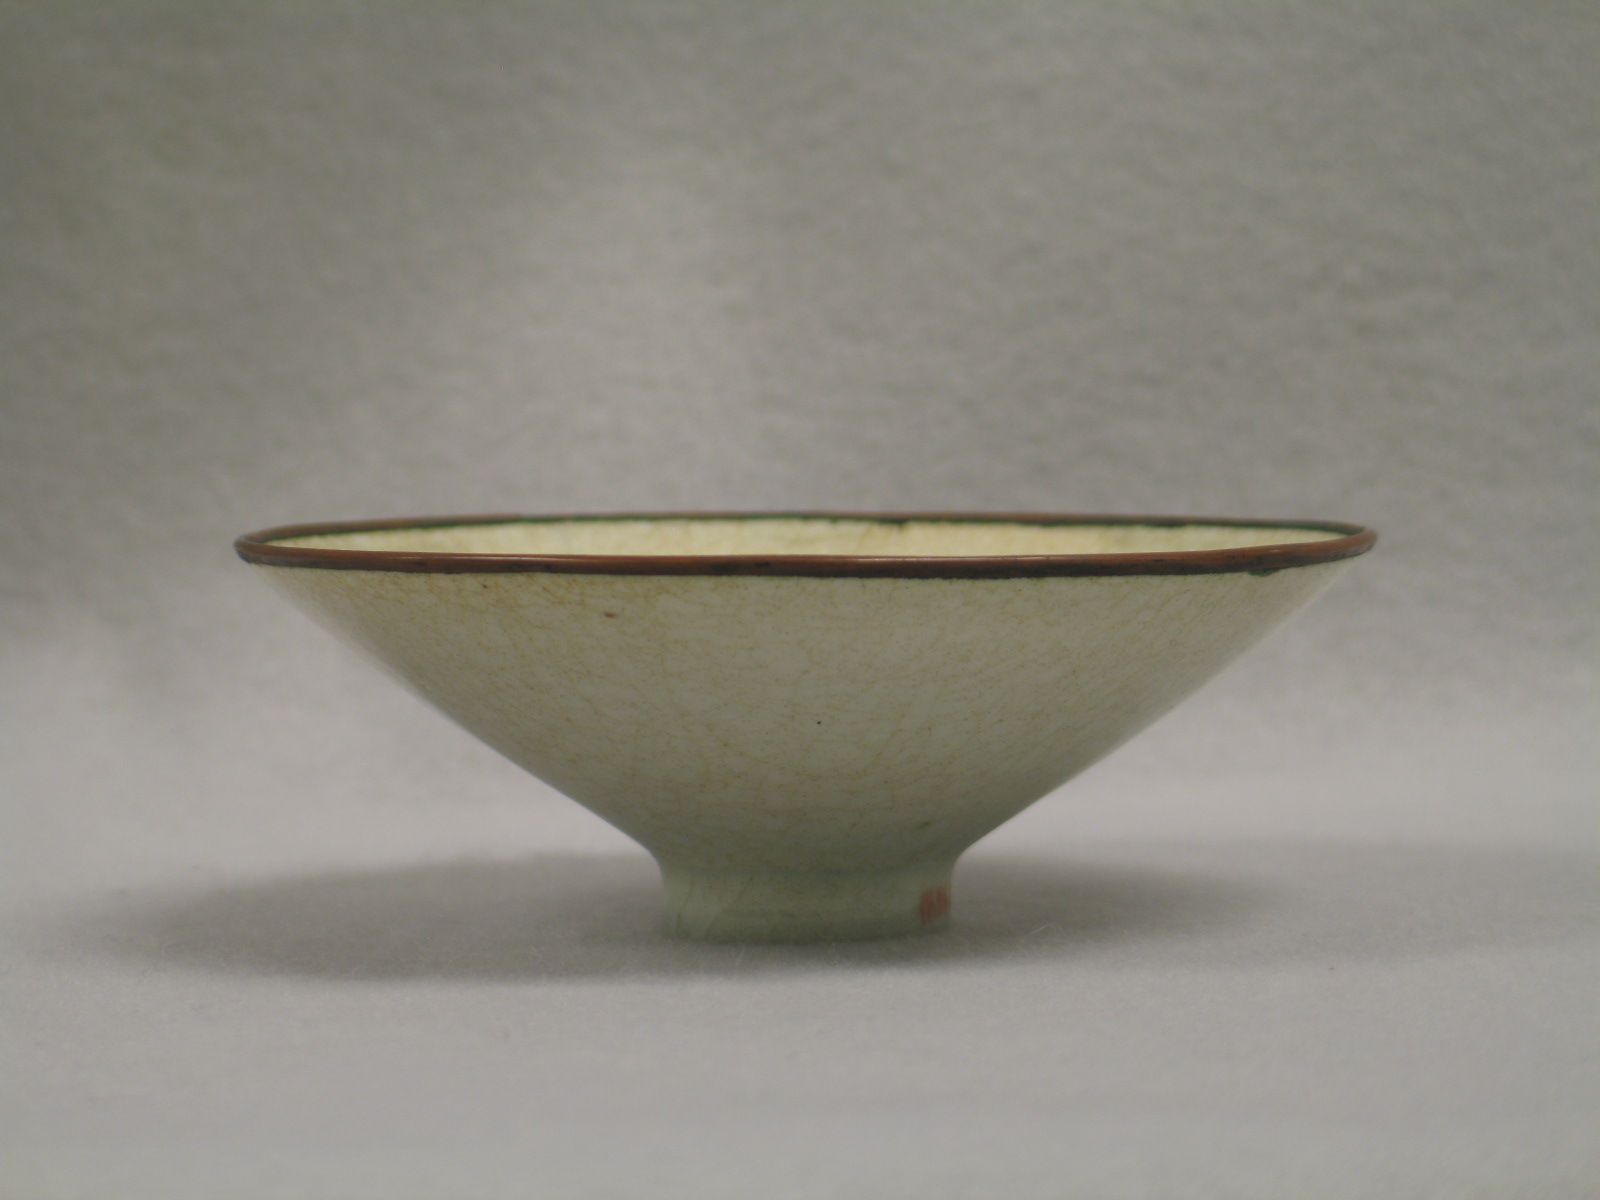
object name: bowl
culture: chinese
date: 1101-1300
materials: copper, glaze, porcelain